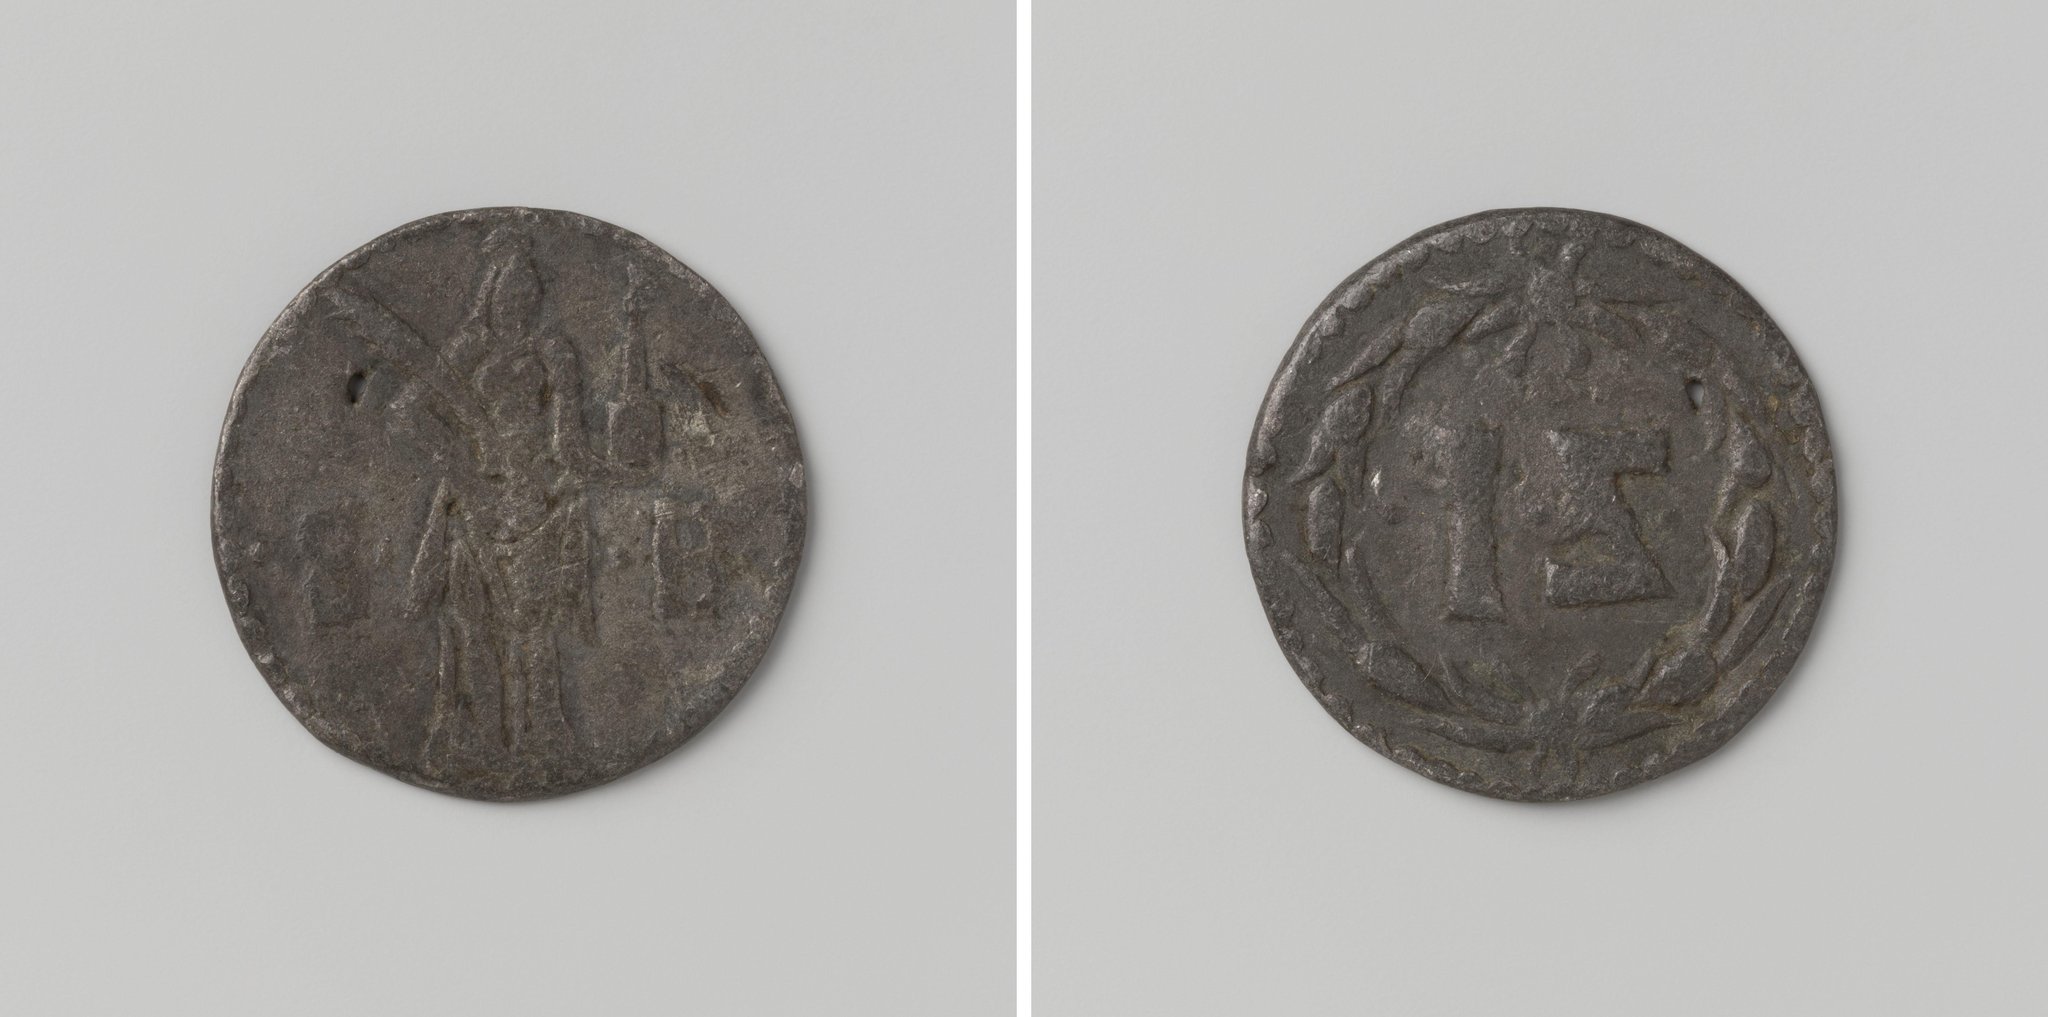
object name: devotional medal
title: Loodje van onbekende plaats met afbeelding van de heilige Barbara, ter waarde van 1 stuiver [?]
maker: Anonymous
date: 1600-1750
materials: lead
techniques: casting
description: Loden penning. Voorzijde: vrouw met veer in rechter- en langwerpig object in linkerhand; ter weerszijden de letters S en B. Keerzijde: opschrift "1 S" binnen krans